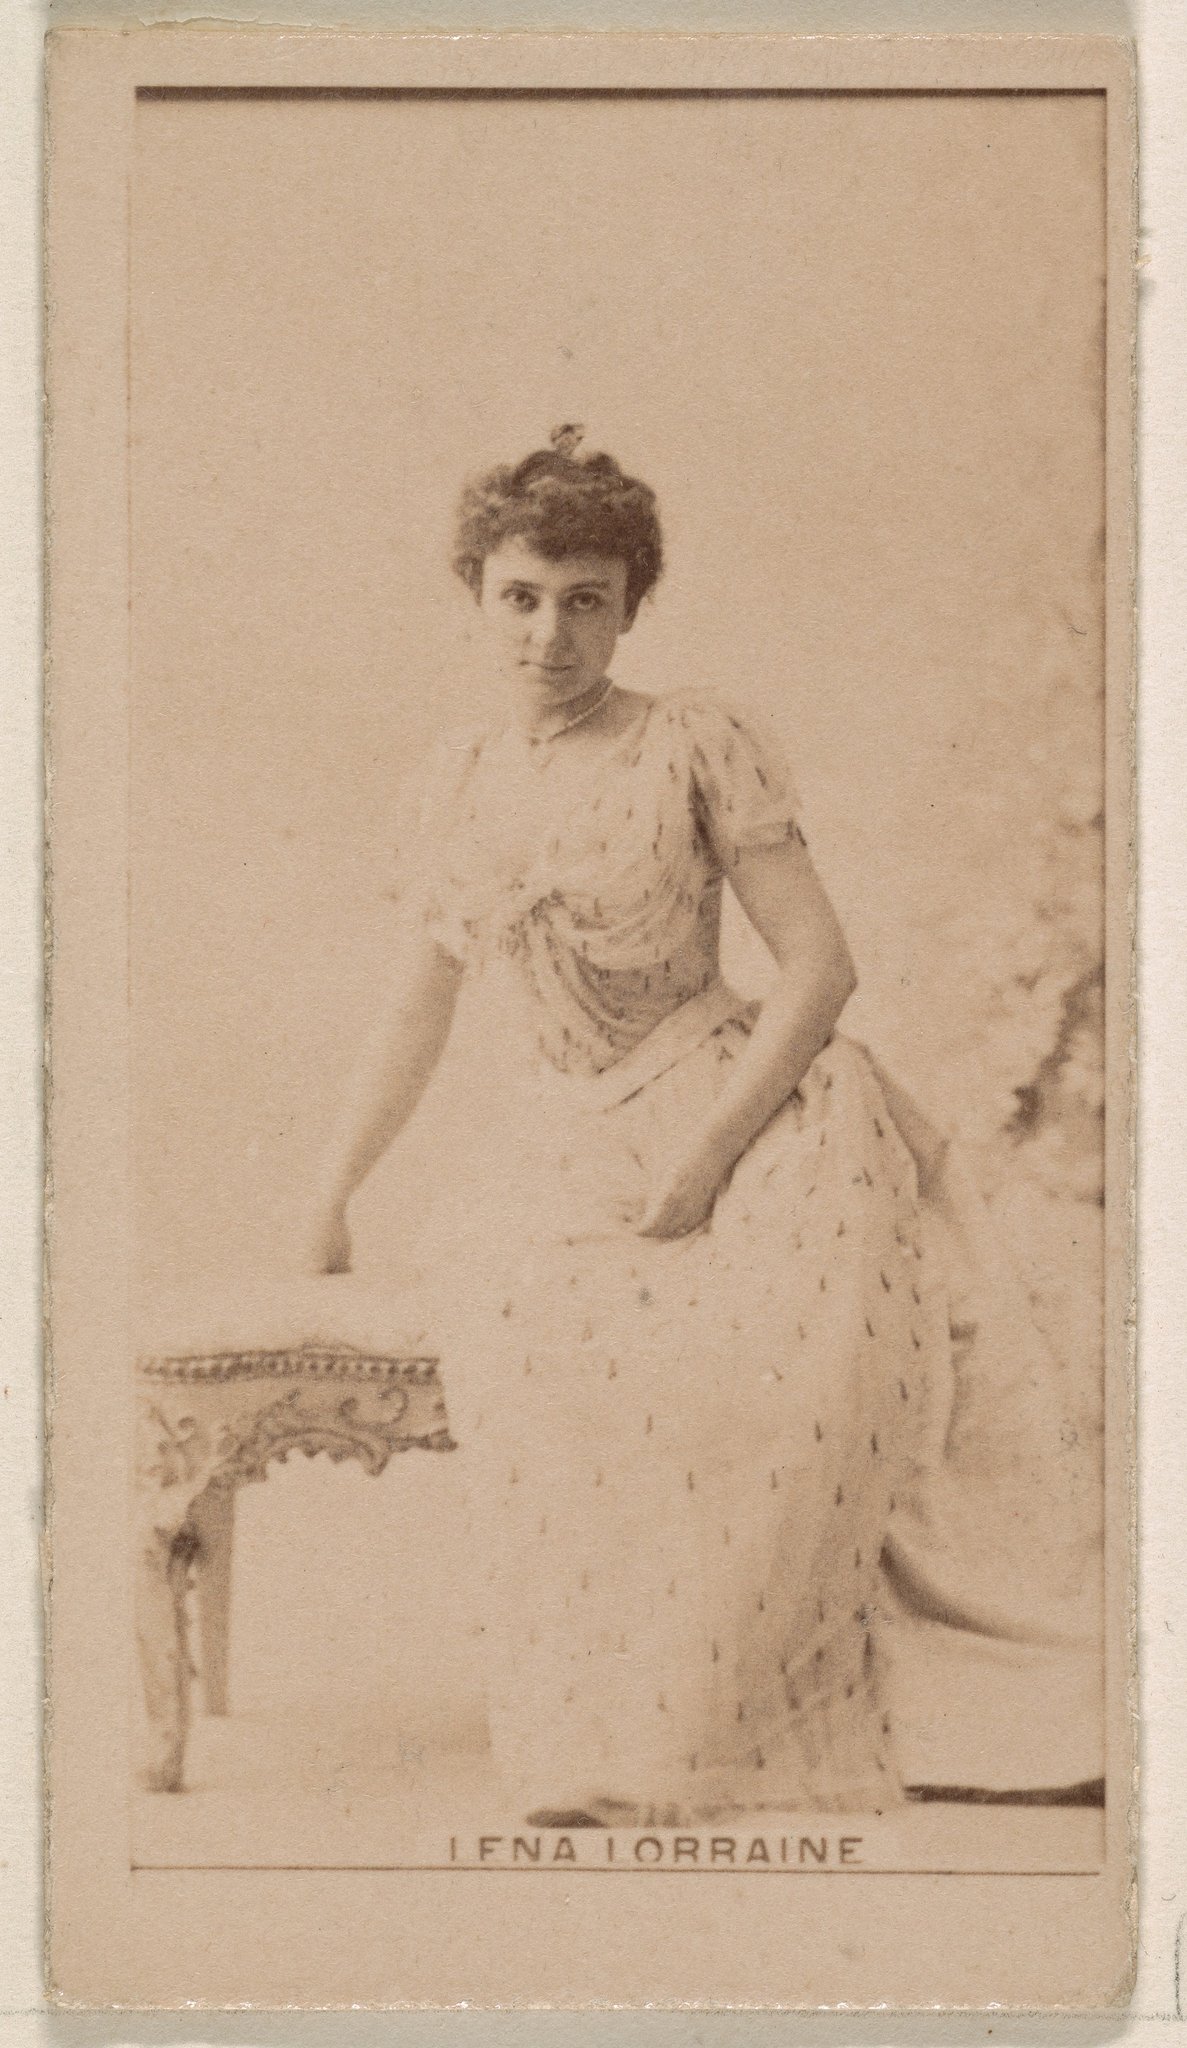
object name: photograph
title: Lena Lorraine, from the Actresses series (N245) issued by Kinney Brothers to promote Sweet Caporal Cigarettes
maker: kinney brothers tobacco company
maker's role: publisher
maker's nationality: american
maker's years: 1869-2011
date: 1890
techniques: albumen silver print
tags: portraits,women,actresses